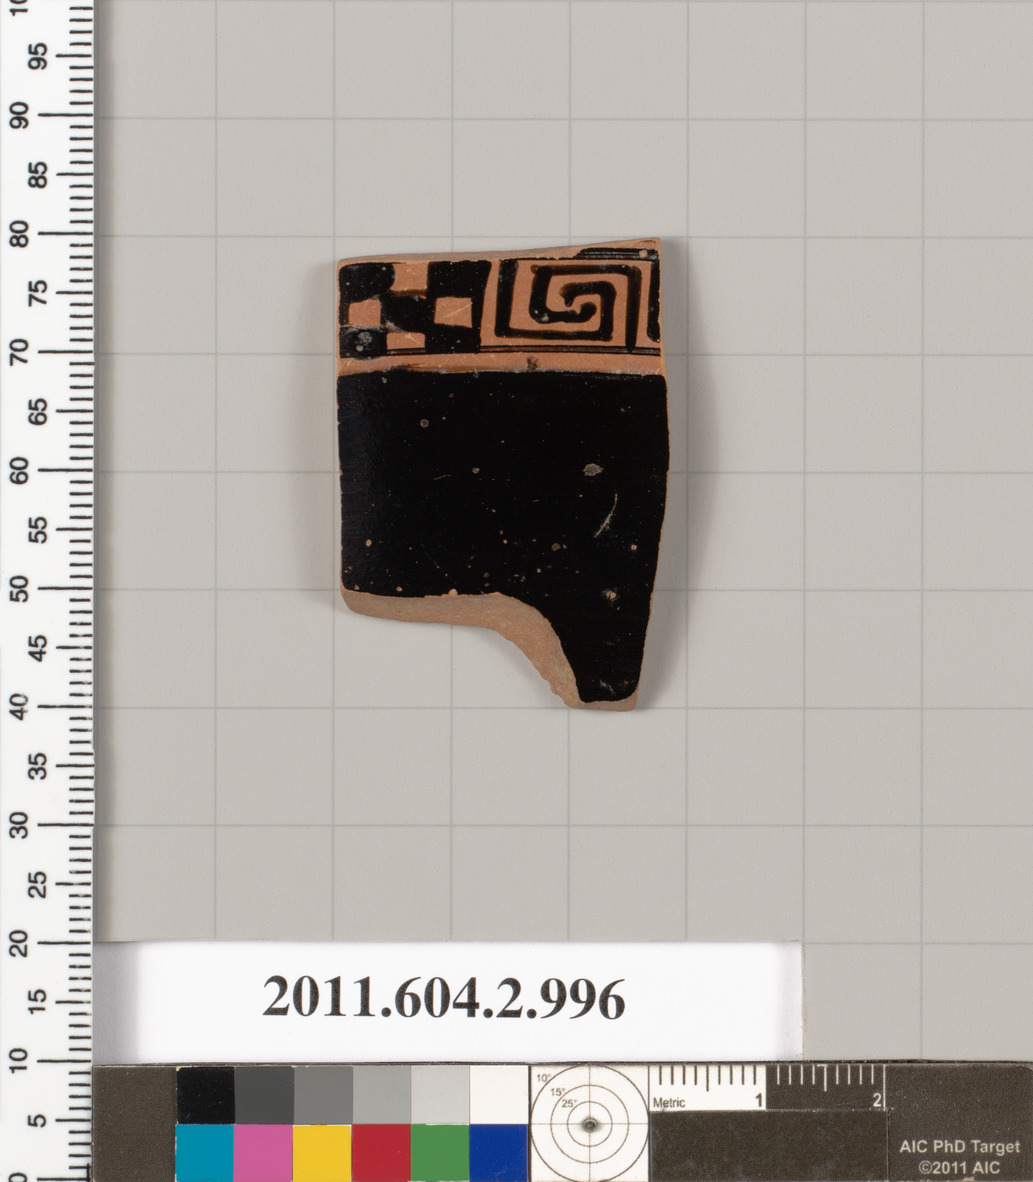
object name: oinochoe fragment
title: Terracotta fragment of an oinochoe (jug)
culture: greek, attic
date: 460-440 BCE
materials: terracotta